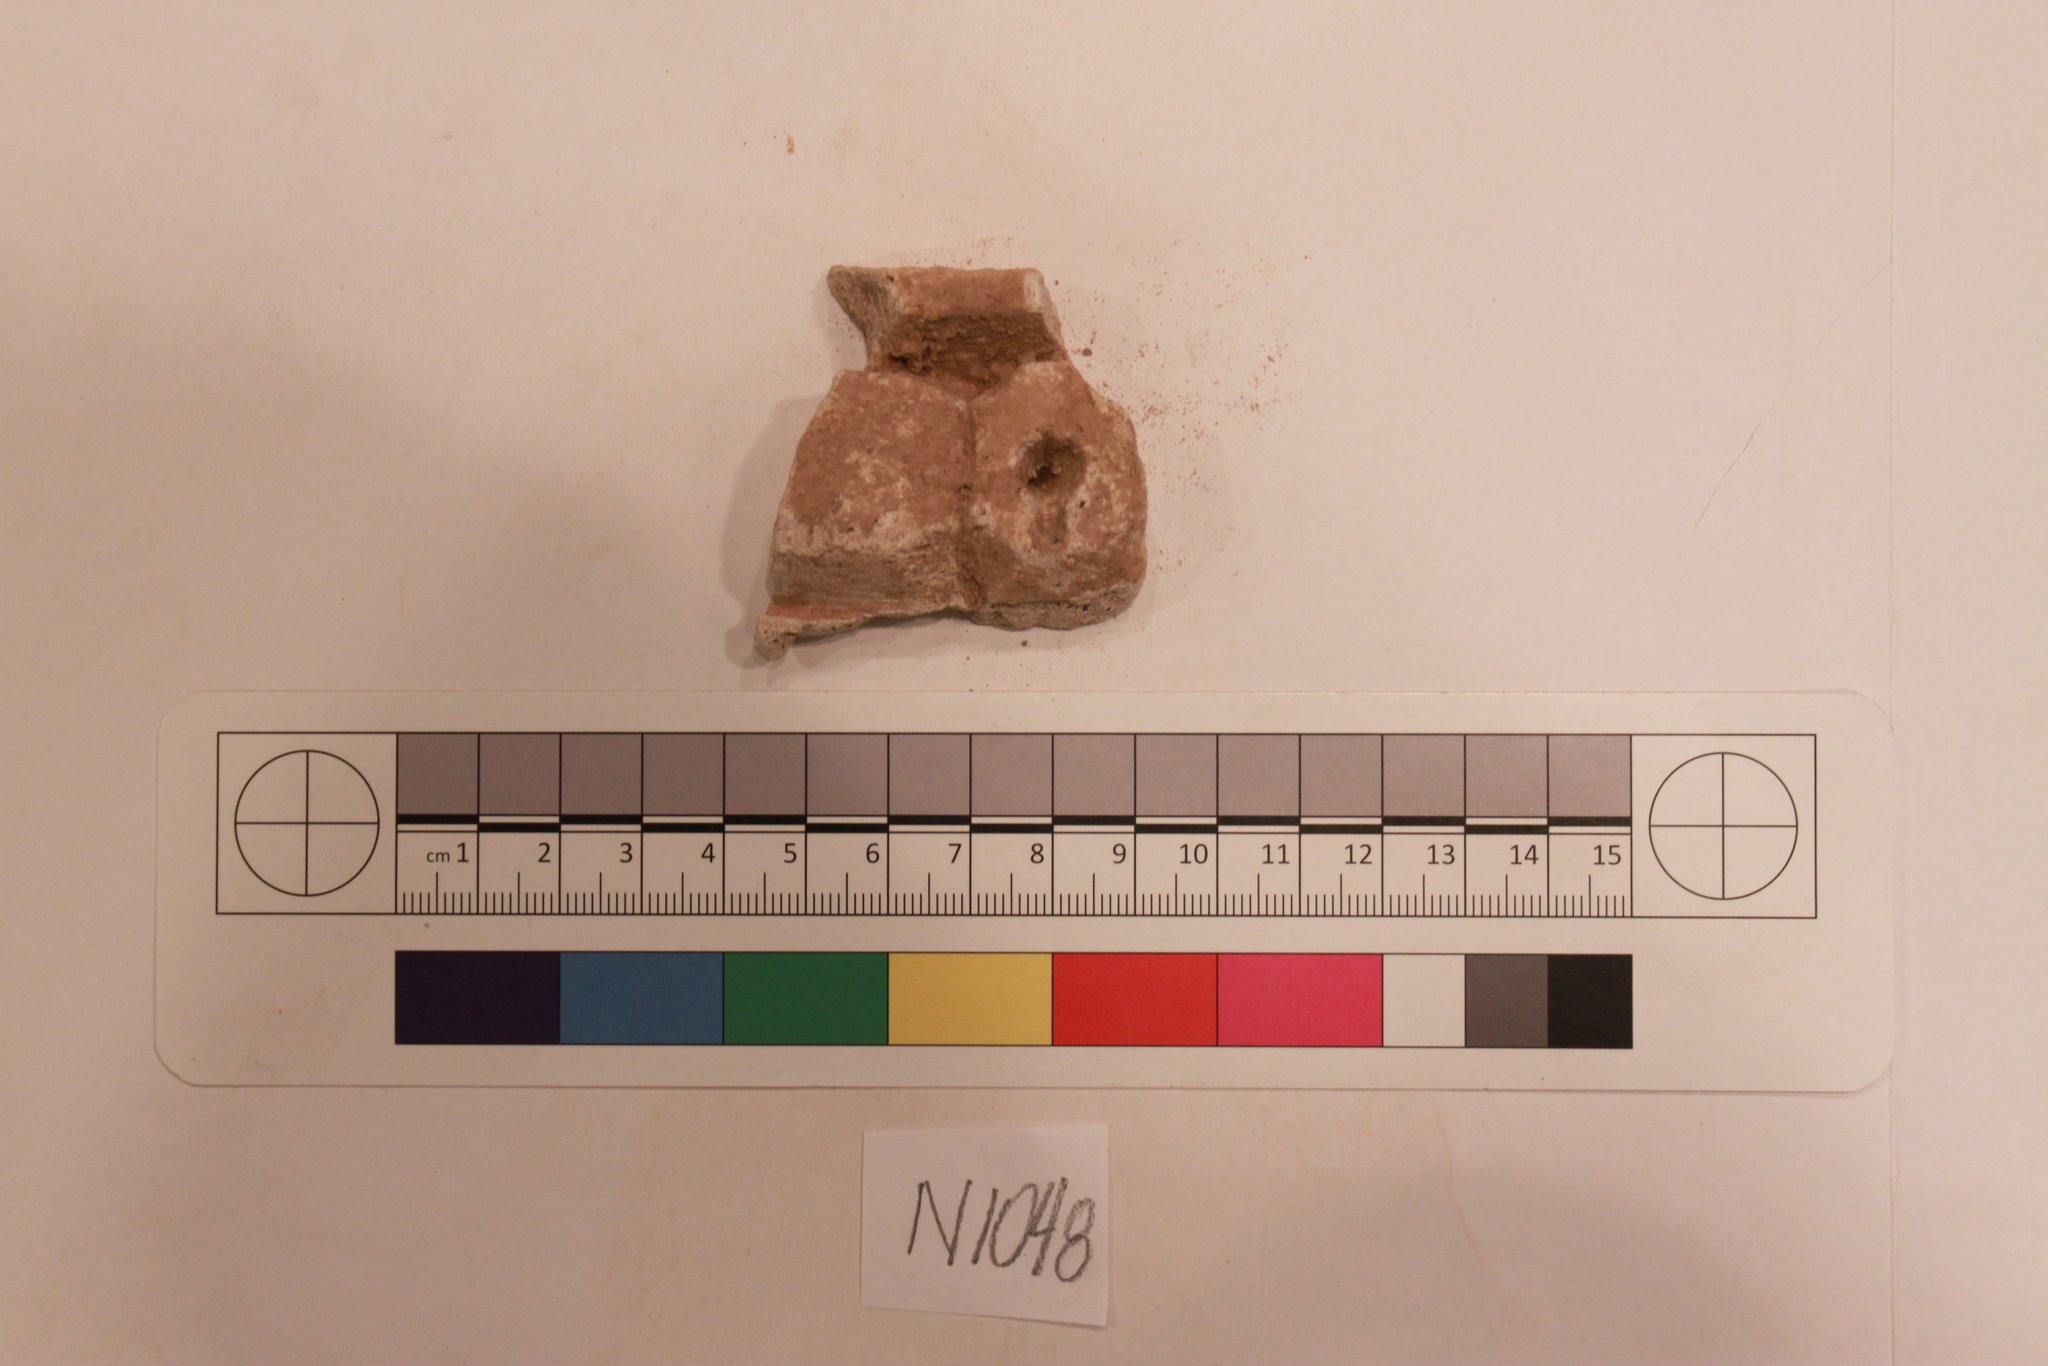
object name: fragment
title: Stucco Fragment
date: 701-1200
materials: plaster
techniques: carving, painting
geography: iran